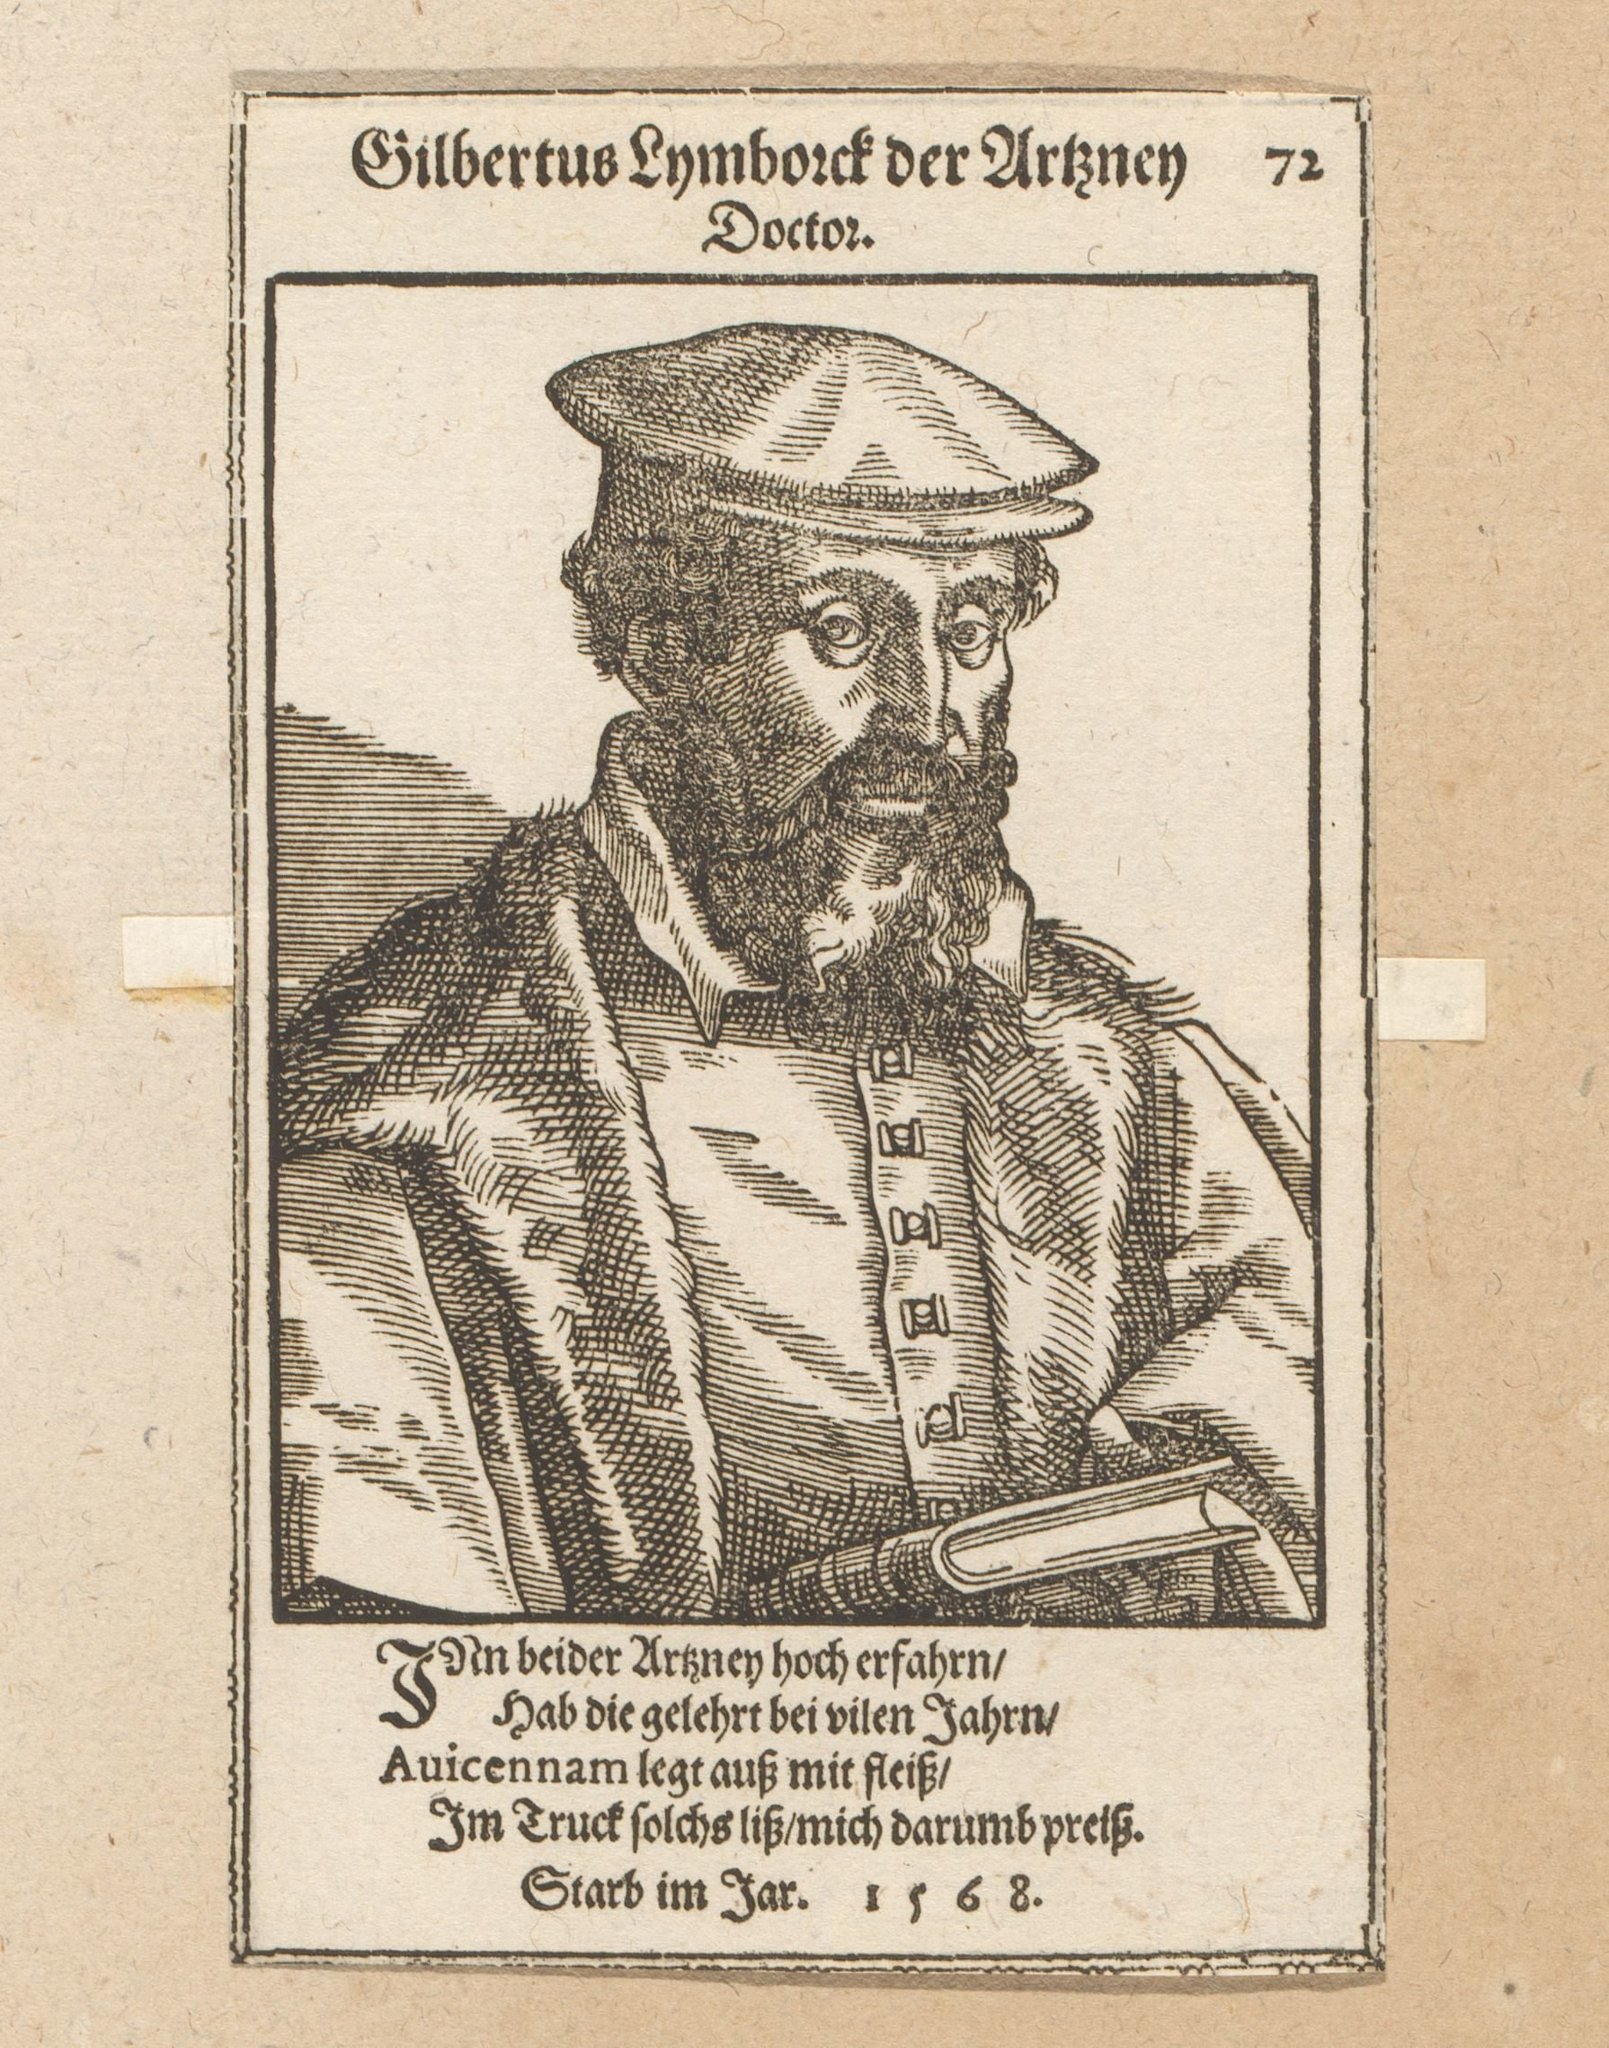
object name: album leaf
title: Portret van Gilbert Fuchs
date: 1568-1587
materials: paper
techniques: letterpress printing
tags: historical persons, physician, doctor (+ portrait of scholar, scientist)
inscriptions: collector's mark: Lugt 240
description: Prent gebruikt in: Reusner, Nikolaus. Contrafacturbuch: ware und Lebendige Bildnussen etlicher weitberümbten unnd Hochgelehrten Männer in Teutschland (...). Straatsburg: Bernhard Jobin, 1587.